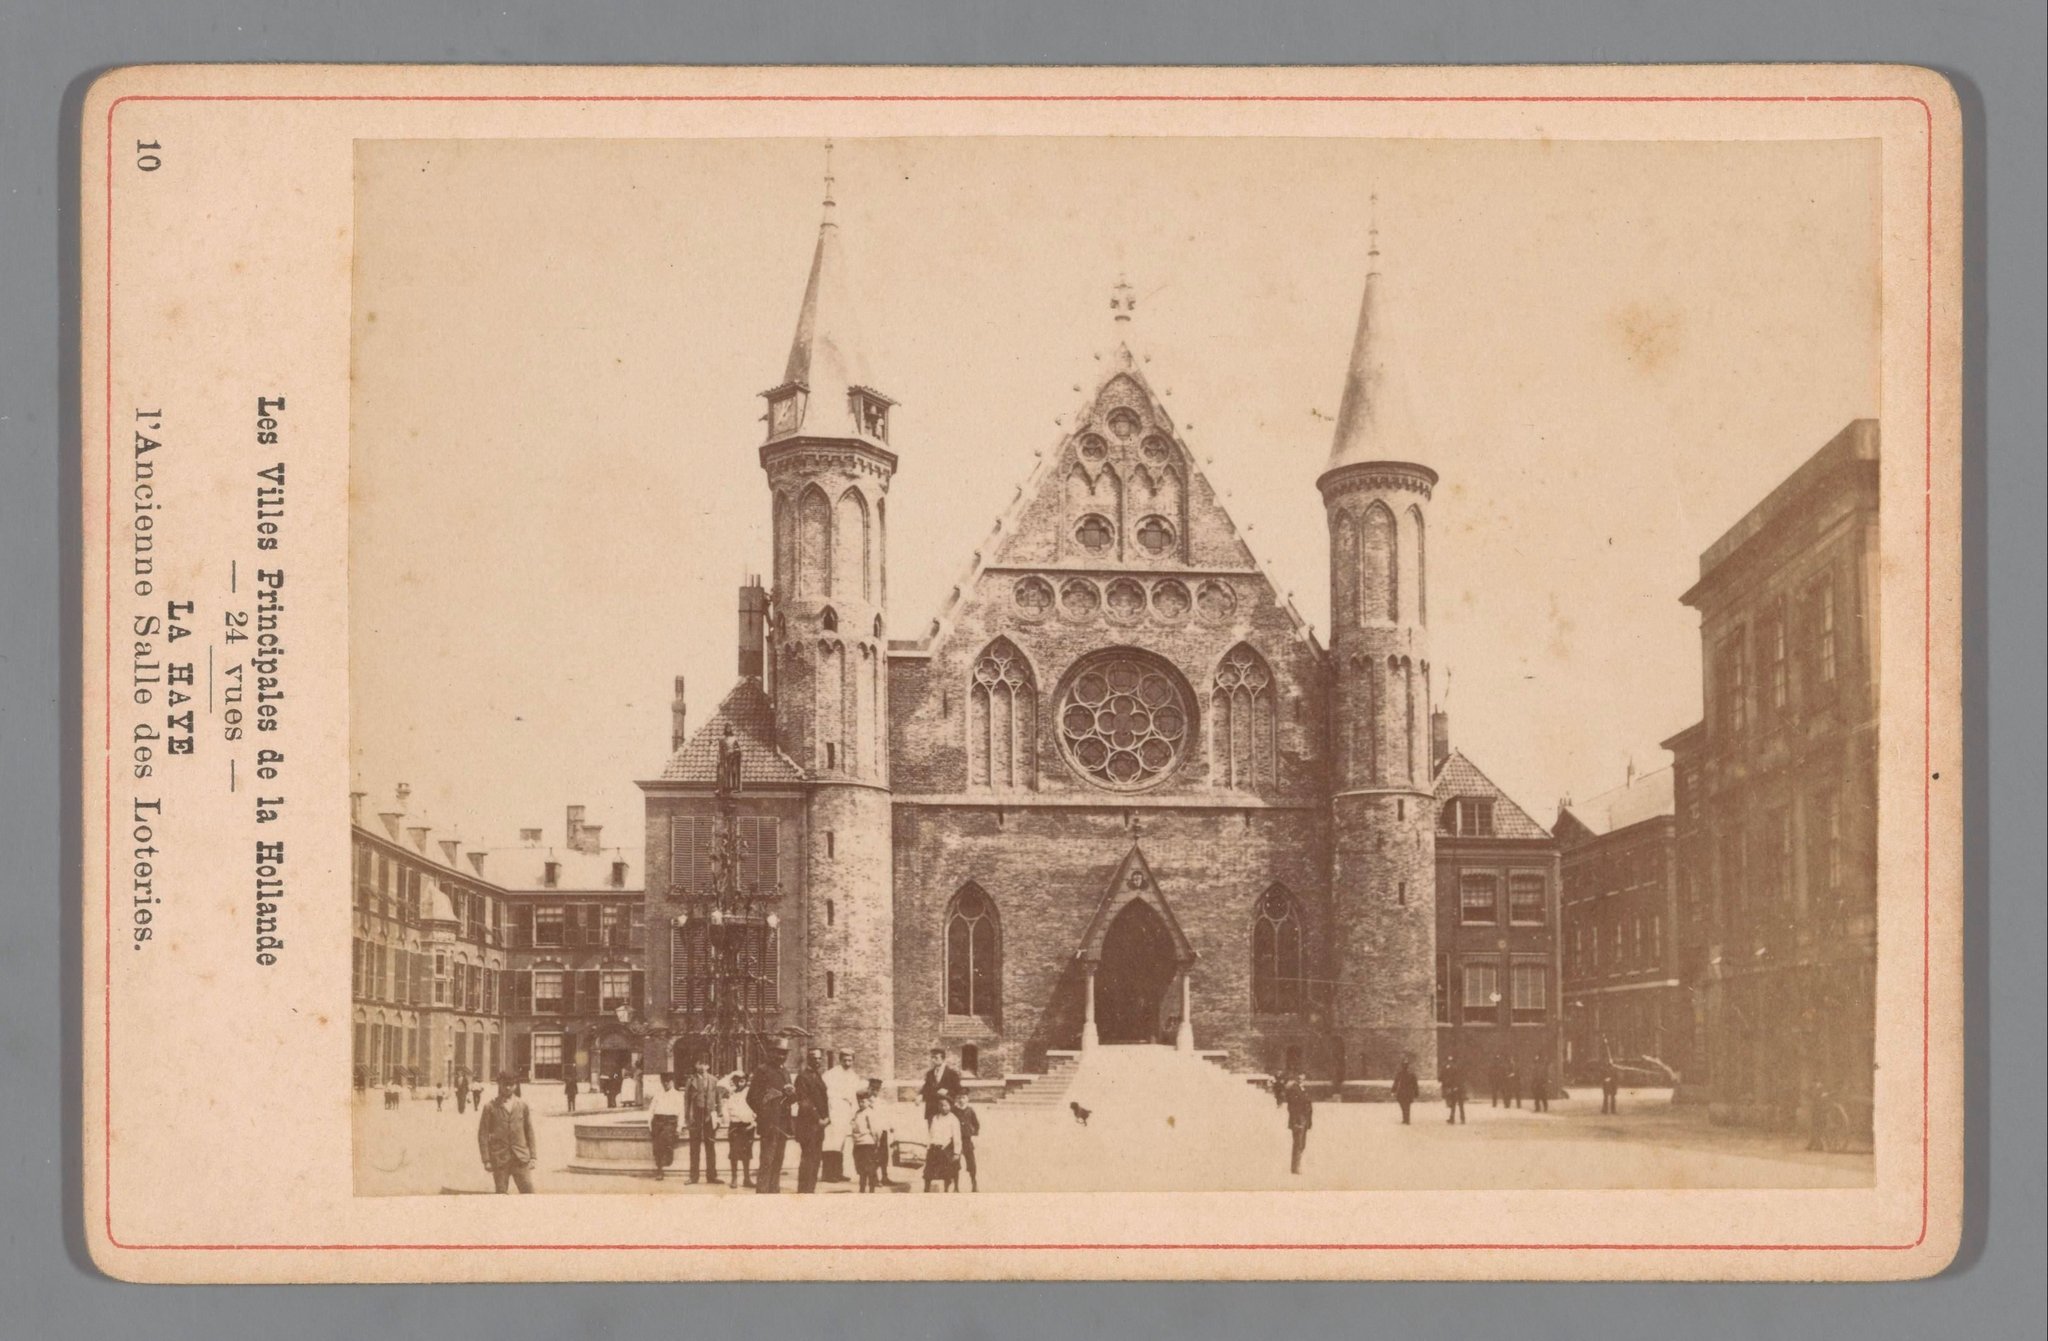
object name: cabinet photograph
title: Gezicht op de Ridderzaal aan het Binnenhof in Den Haag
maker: Anonymous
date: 1877-1900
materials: cardboard, photographic support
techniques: albumen print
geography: binnenhof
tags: front façade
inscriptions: number: ‘10’, annotation: ‘uw ke[...] in 1880/ van s[.]h[...] in [...] staat/ (geem[...] 1904)’